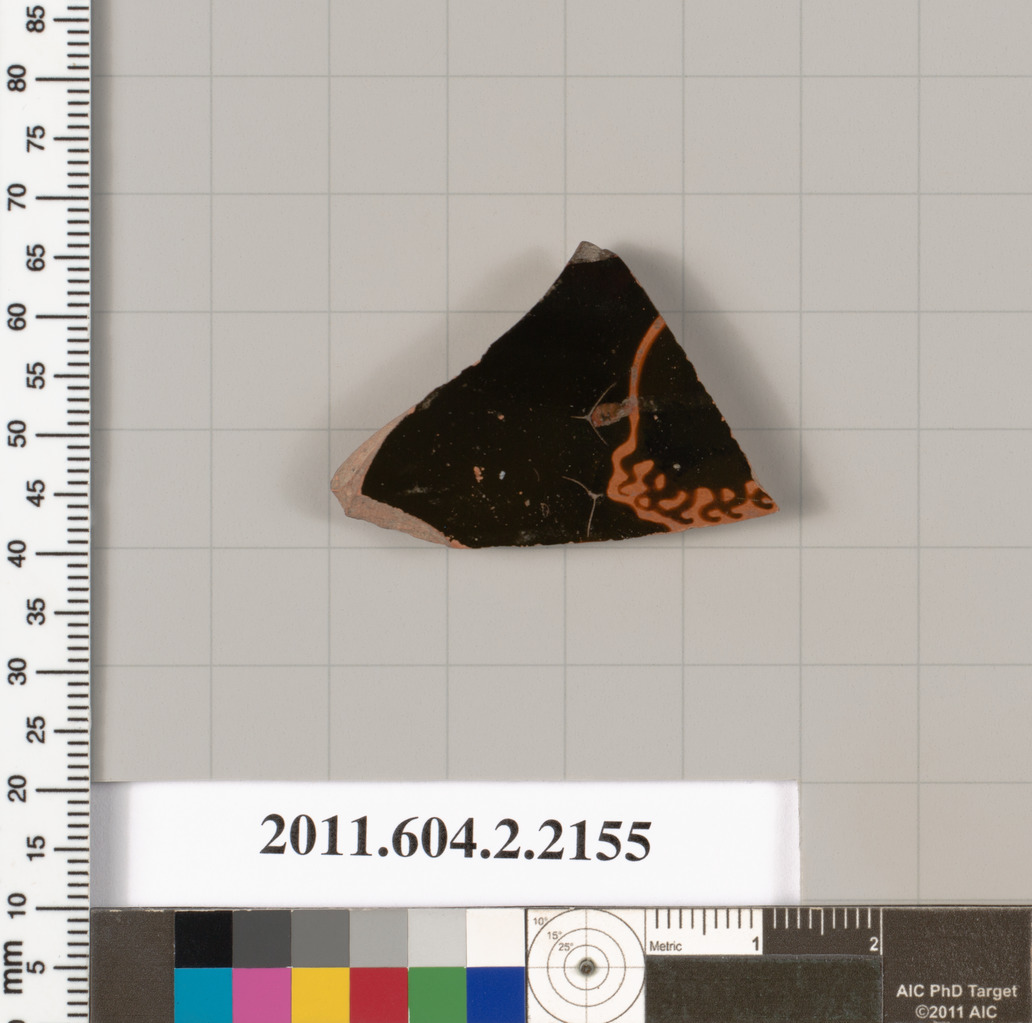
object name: pot fragment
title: Terracotta fragment of a pot; unglazed on the inside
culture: greek, attic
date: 475-451 BCE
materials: terracotta